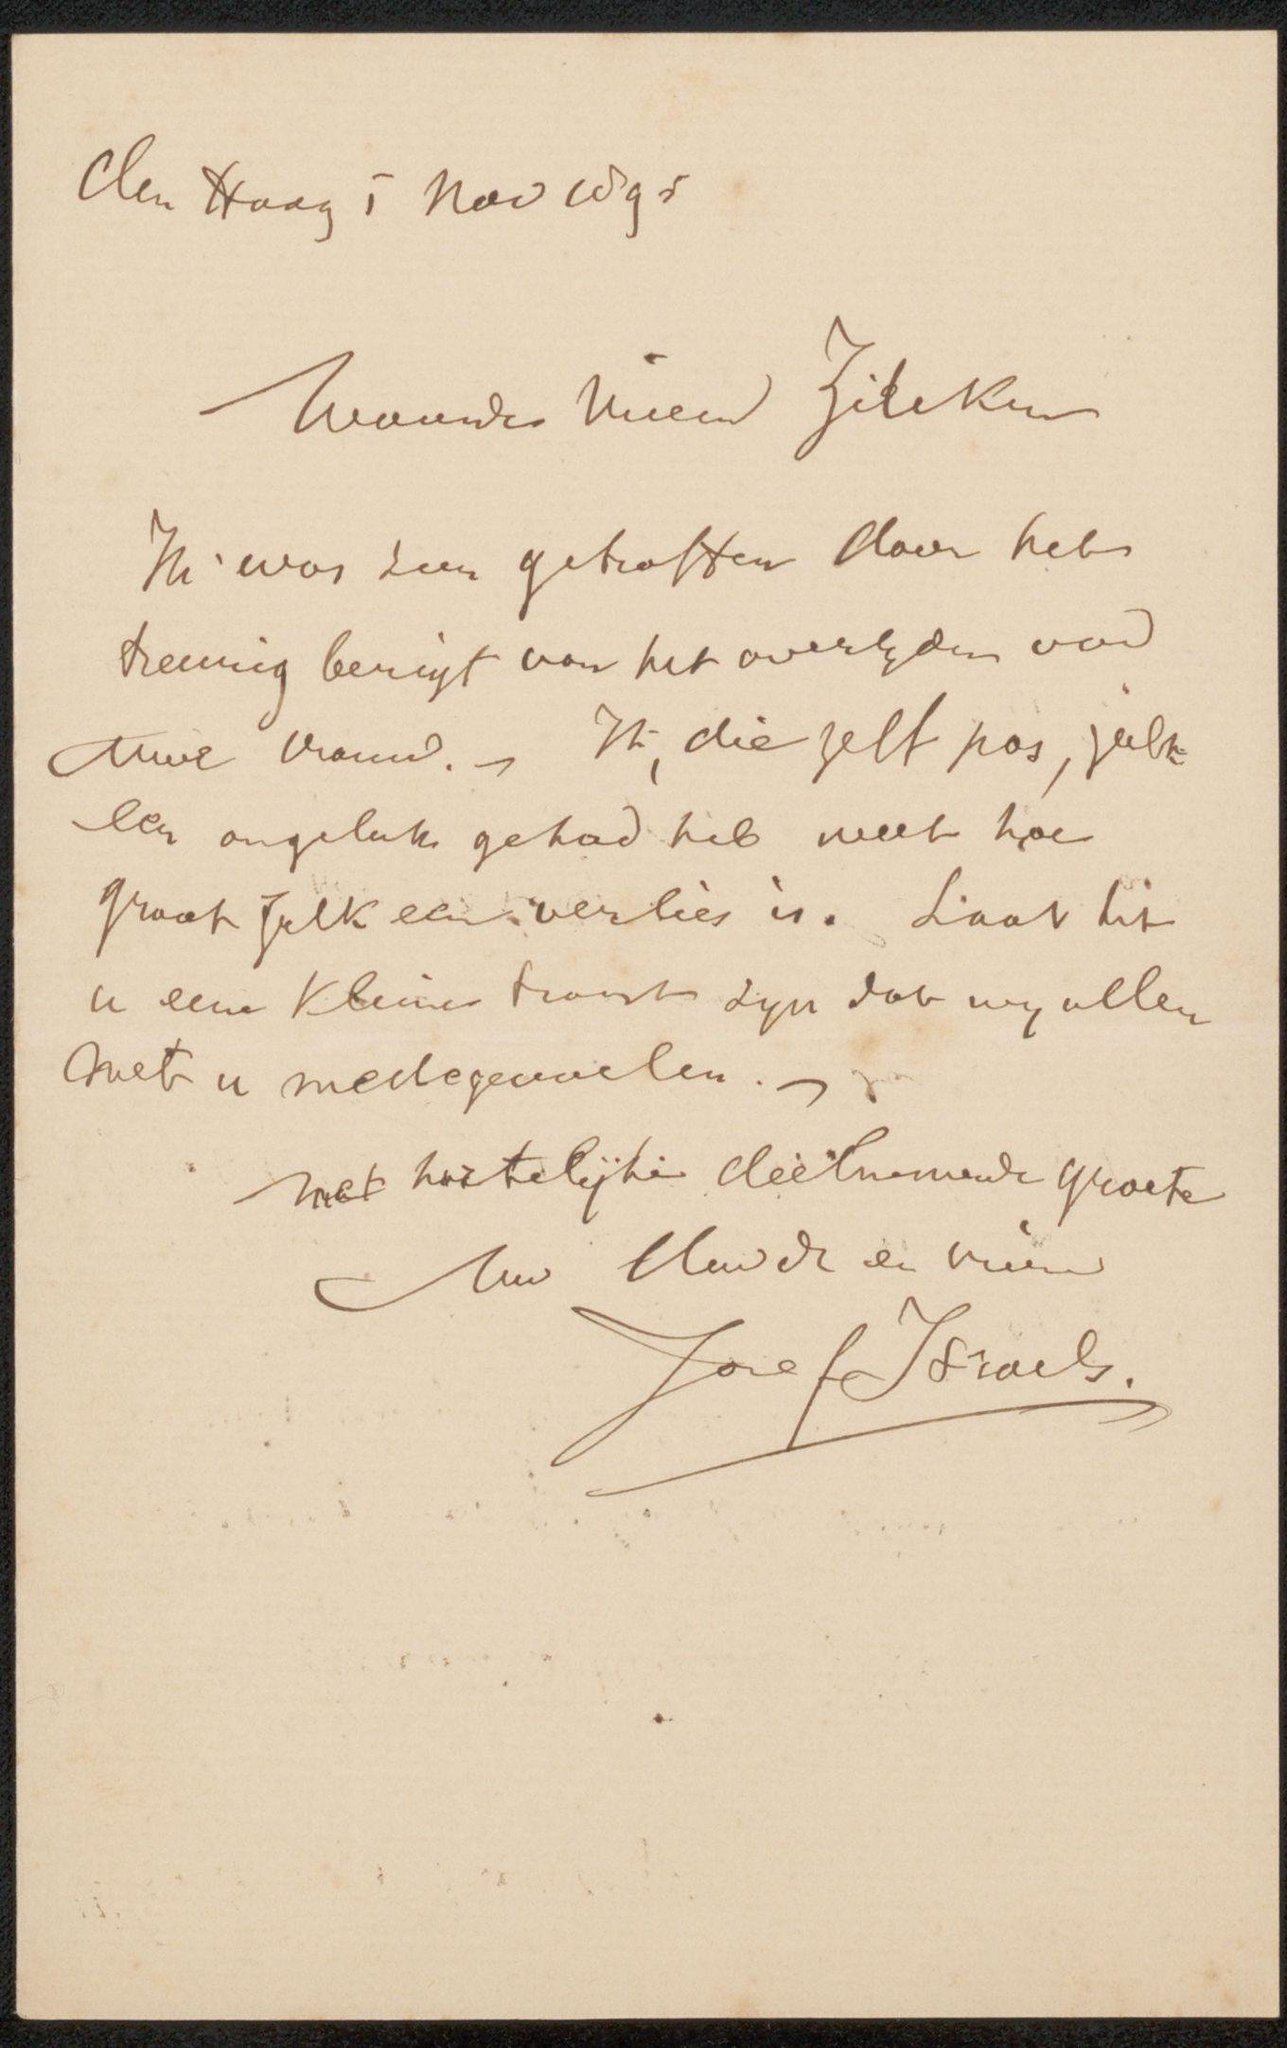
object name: letter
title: Brief aan Philip Zilcken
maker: jozef israëls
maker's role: draughtsman, painter, print maker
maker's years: 1824-1911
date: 1895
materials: ink, paper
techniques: pen, writing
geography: the hague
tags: brussels, helène lambertine hauzeur, painter, draughtsman, philip zilcken, family life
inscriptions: collector's mark: ‘RPK’